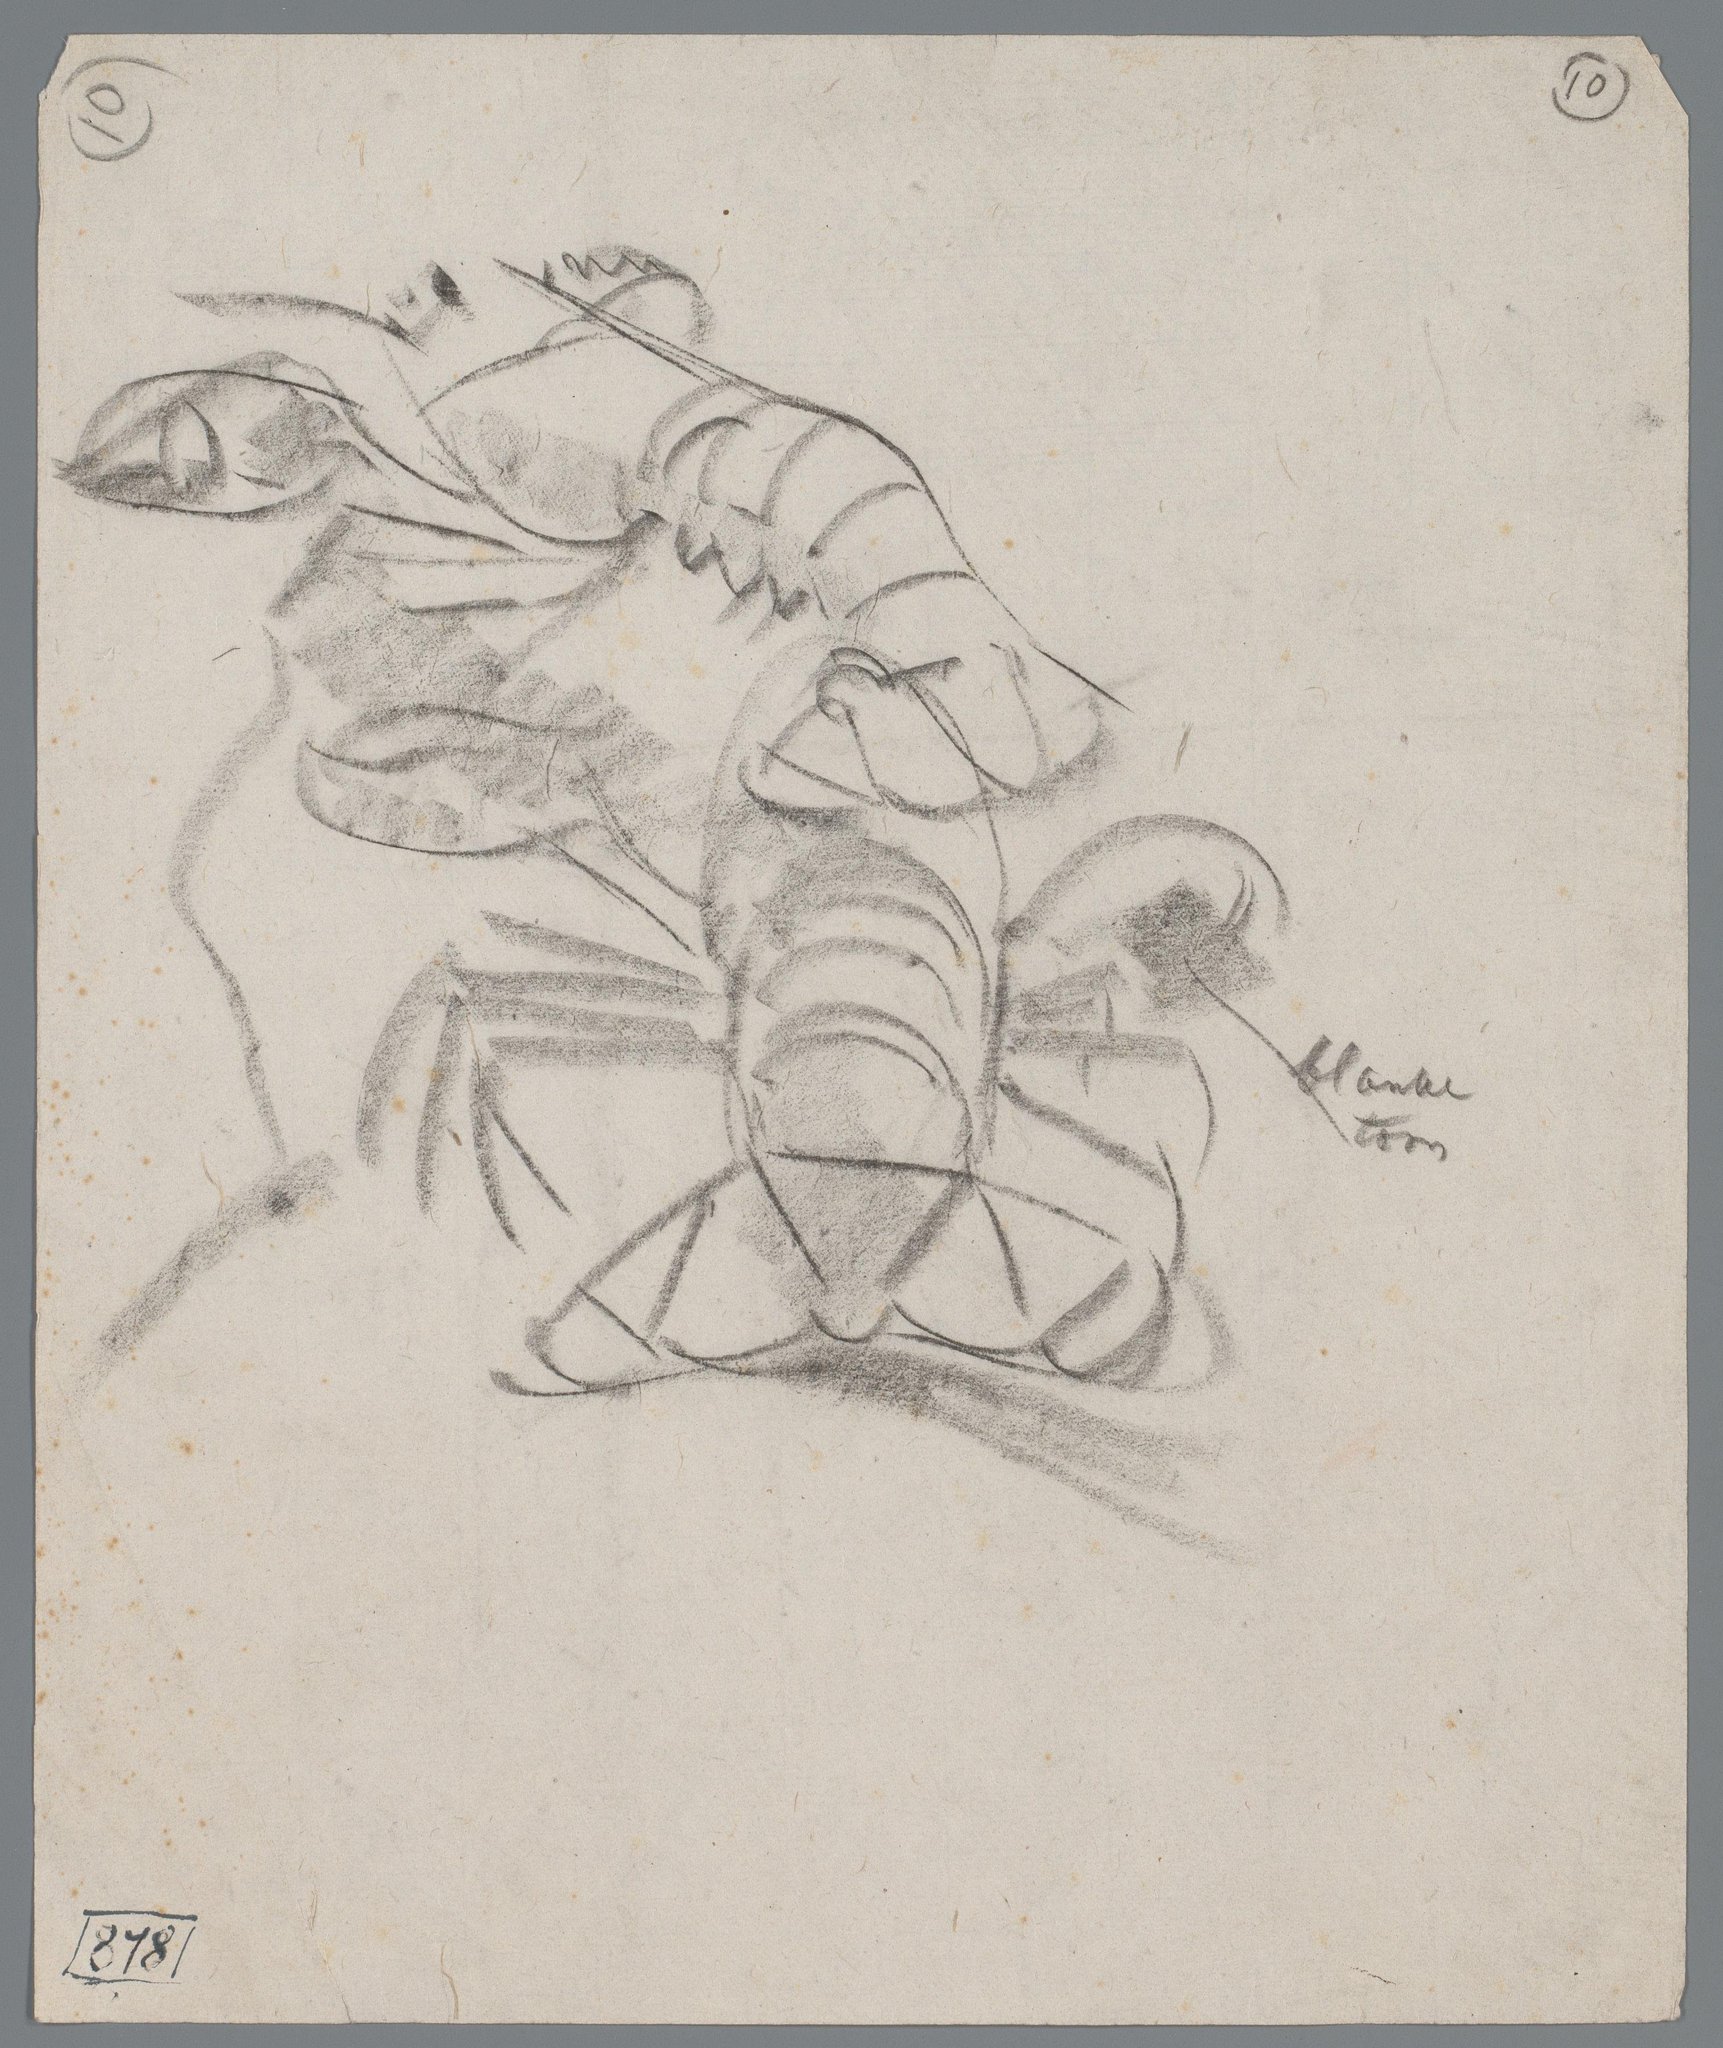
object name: drawing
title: Studie van een kreeft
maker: gerrit willem dijsselhof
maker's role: designer, draughtsman, print maker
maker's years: 1866-1924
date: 1876-1924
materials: chalk, paper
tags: crustaceans: lobster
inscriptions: number: ‘10’, number: ‘878’